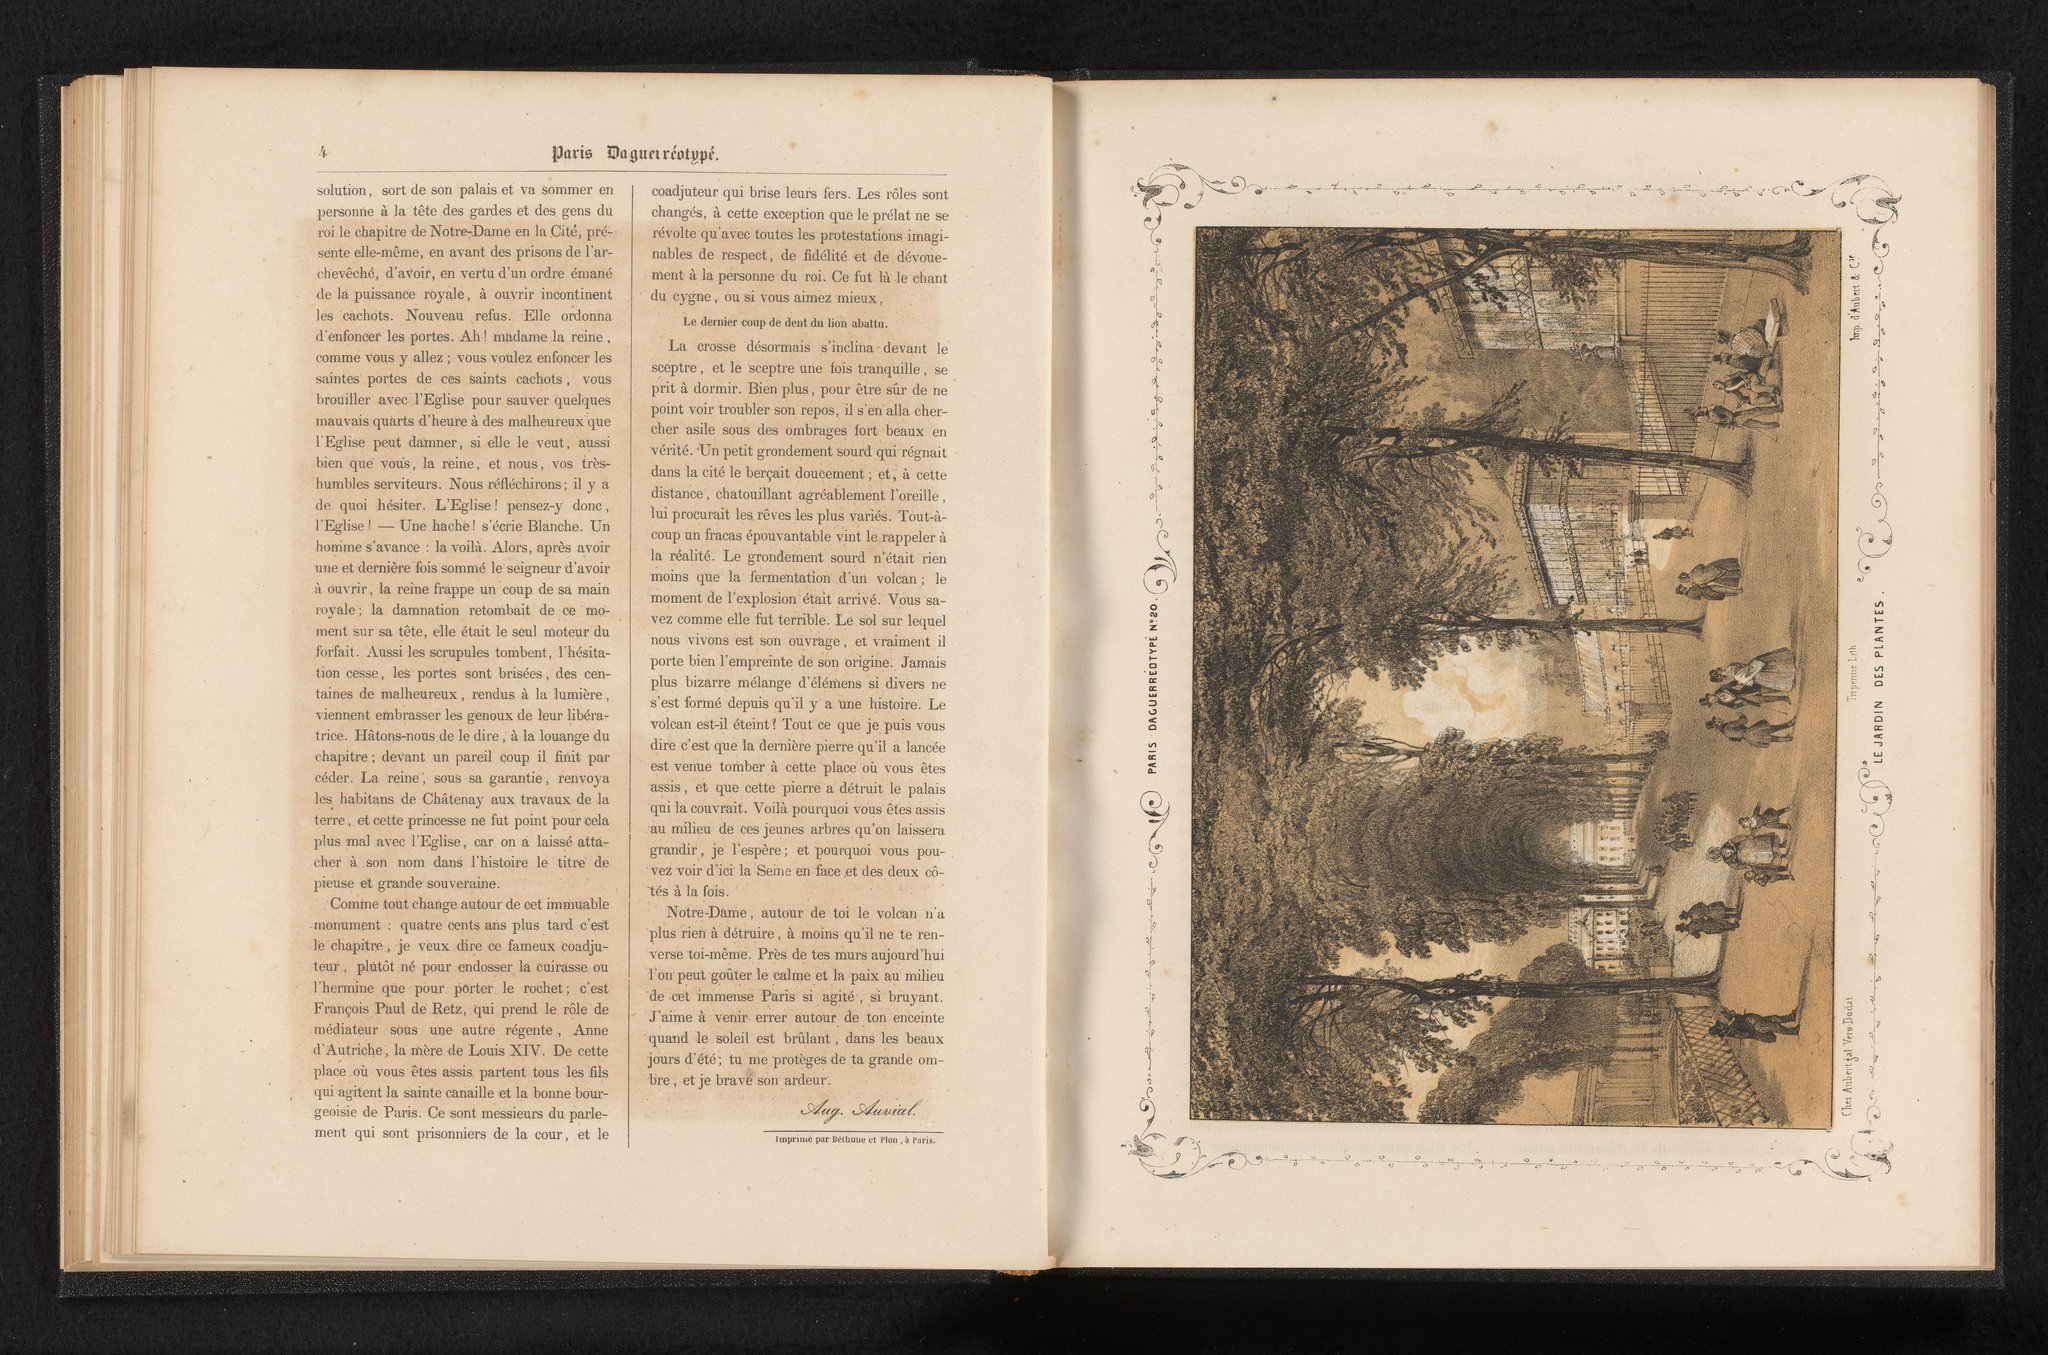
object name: page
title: Le Jardin des Plantes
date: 1839-1840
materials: paper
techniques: tone lithography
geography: paris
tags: botanic garden, 'hortus botanicus'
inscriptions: inscription: ‘PARIS DAGUERRÉOTYPÉ No. 20.’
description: Prent op negenenzeventigste ongenummerde pagina.